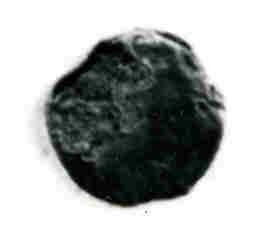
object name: coin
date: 401-1400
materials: copper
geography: iran